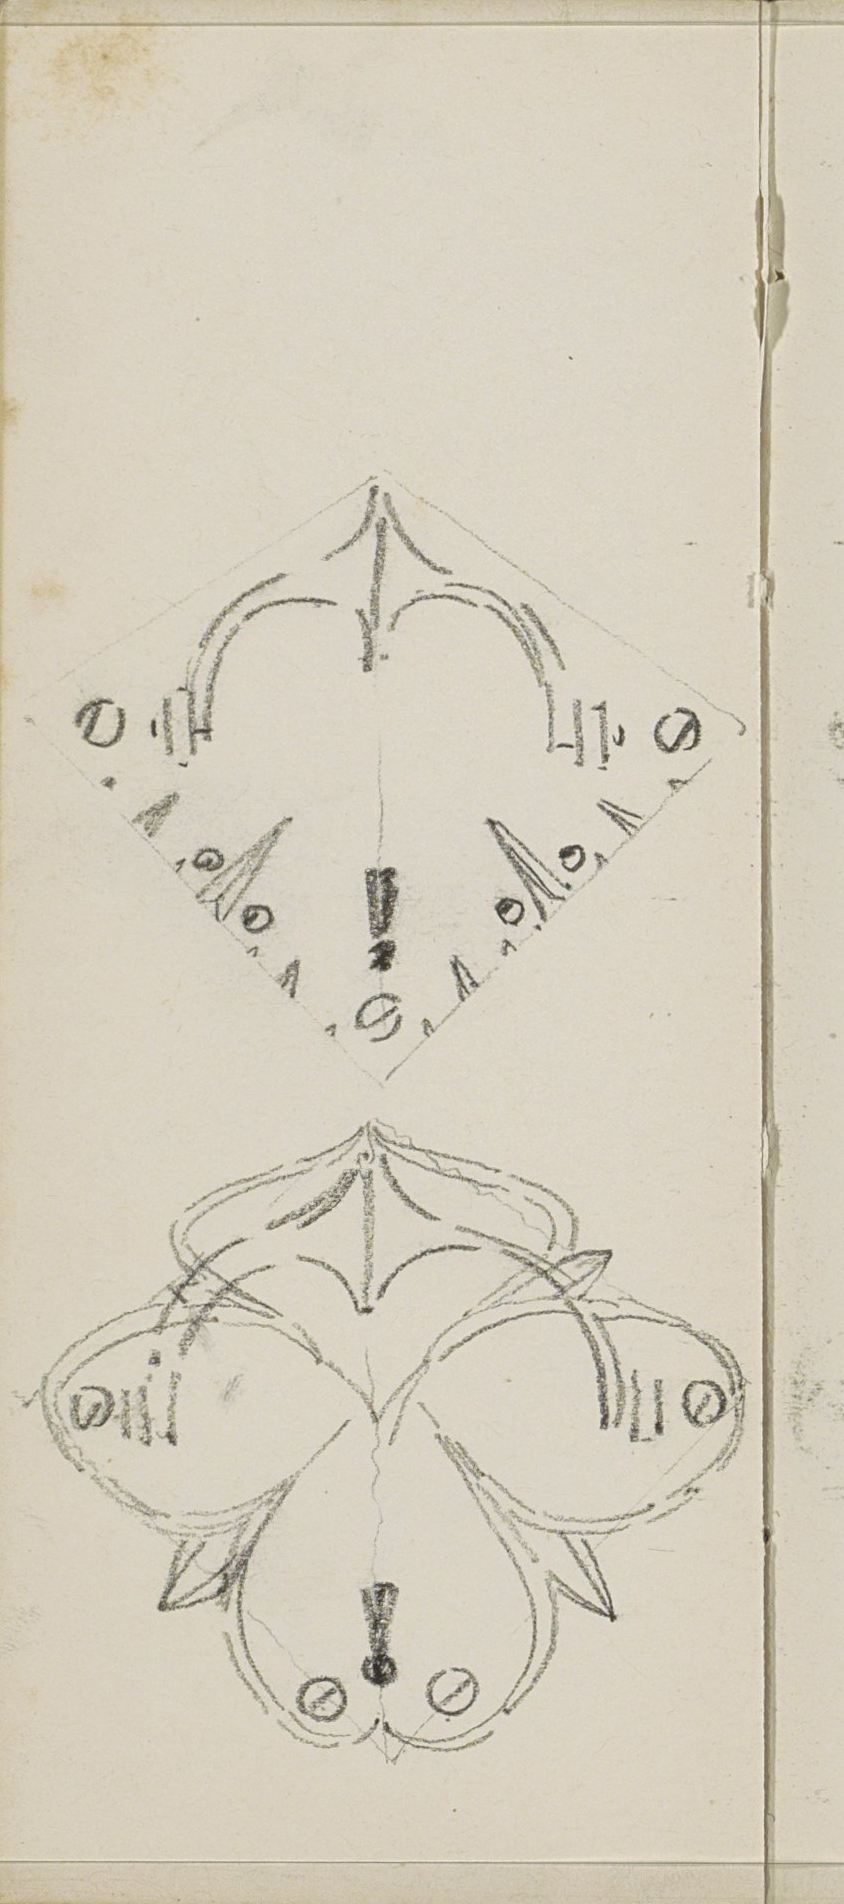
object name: sketchbook leaf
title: Ruitvormig en een floraal ornament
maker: gerrit willem dijsselhof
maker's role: designer, draughtsman, print maker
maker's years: 1866-1924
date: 1876-1924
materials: chalk, paper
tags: foliage, tendrils, branches ~ ornament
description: Blad 37 verso uit een schetsboek met 40 bladen.